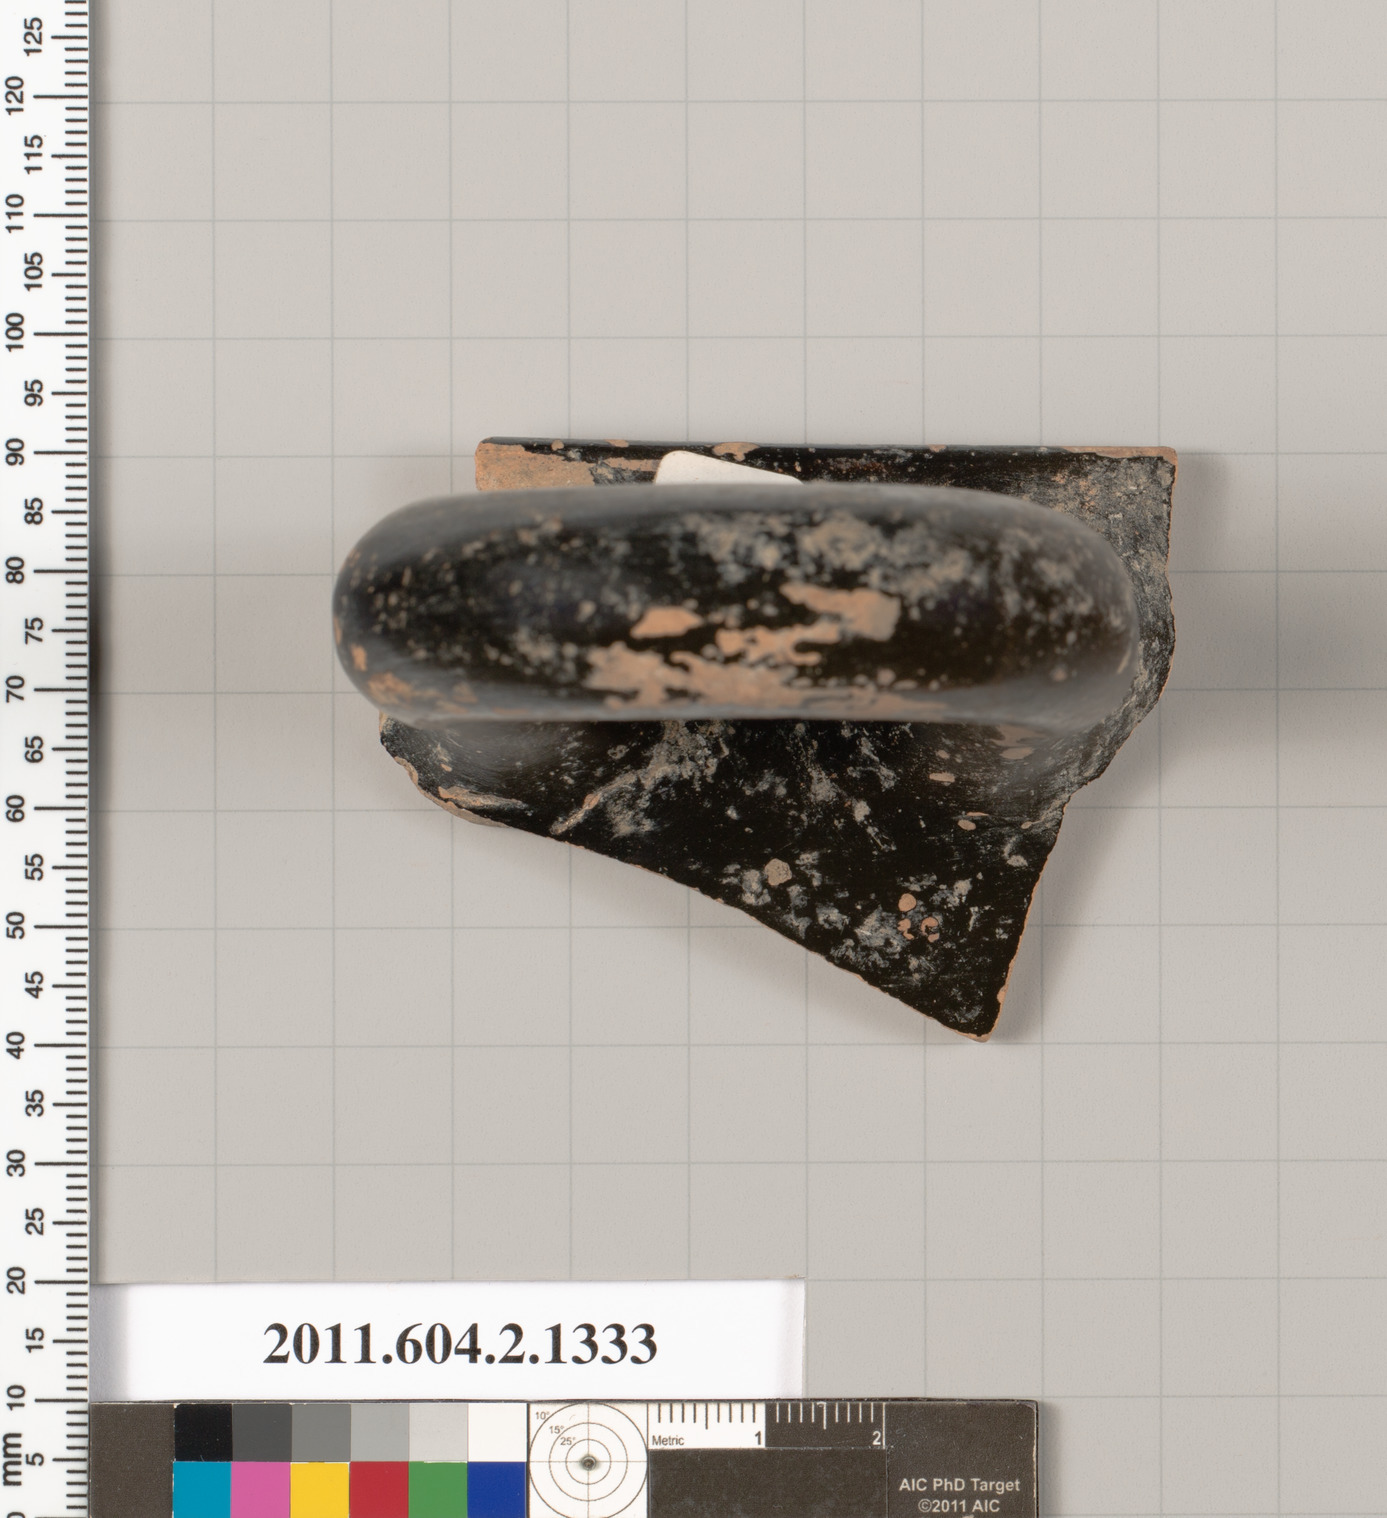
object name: skyphos fragment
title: Terracotta fragment of a skyphos (deep drinking cup)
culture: greek, attic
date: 500-451 BCE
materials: terracotta